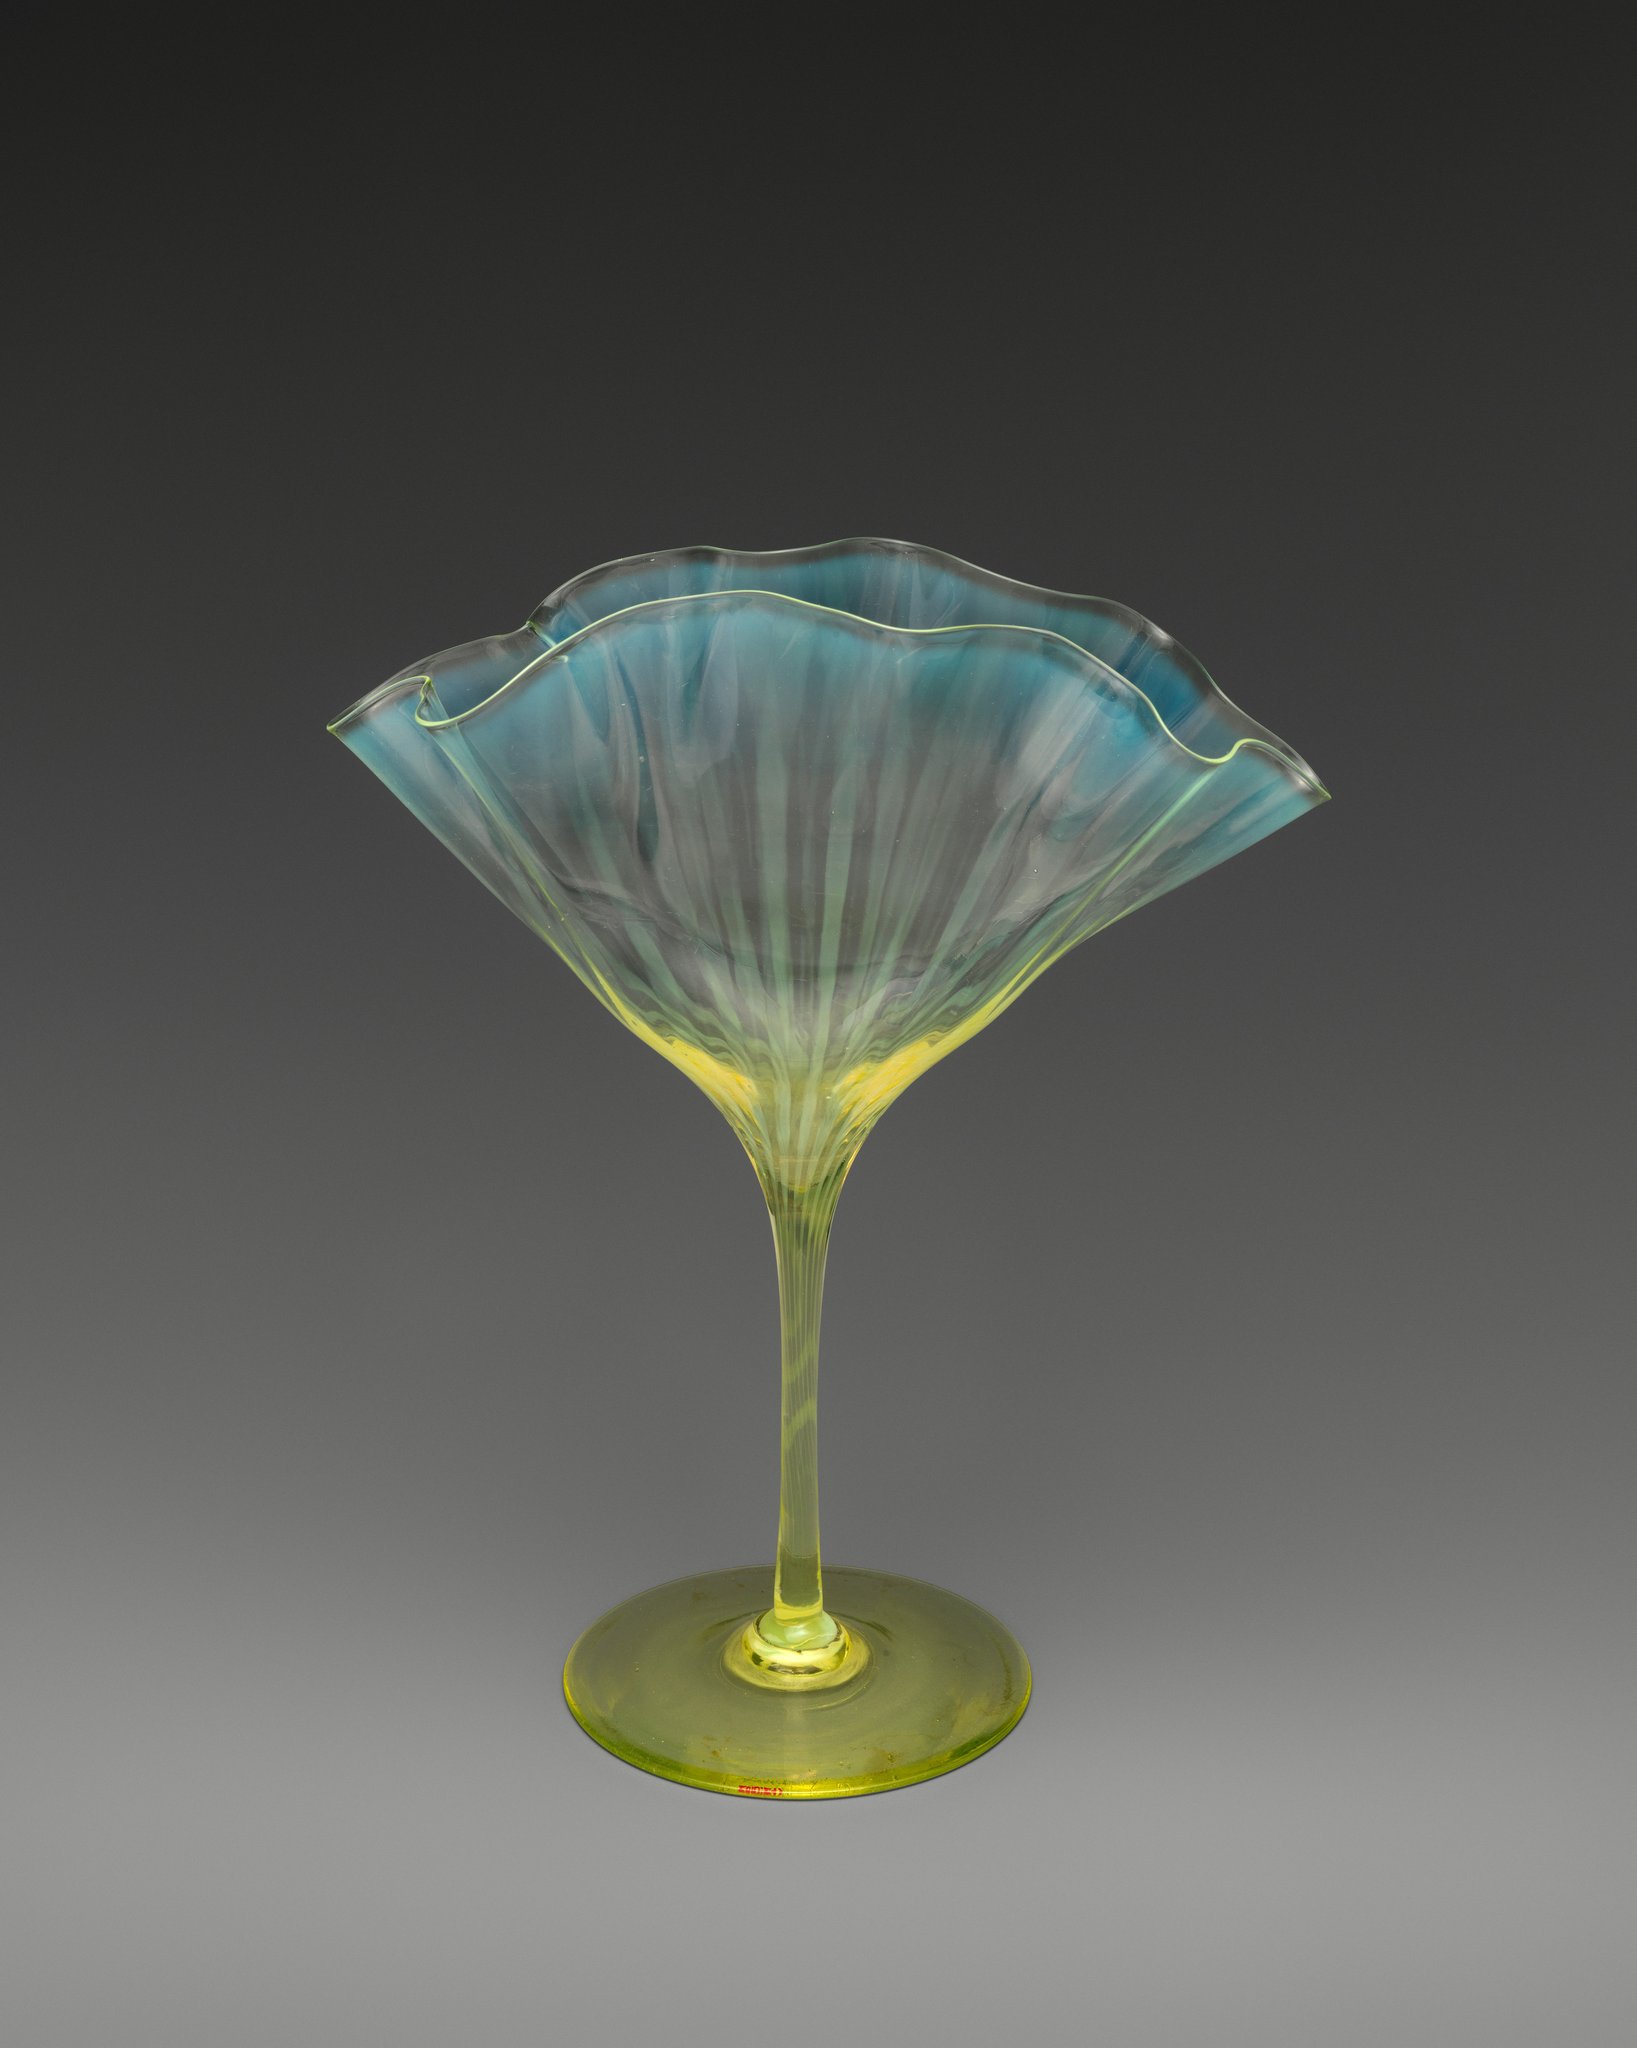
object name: vase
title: Fan-shaped vase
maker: harry powell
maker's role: designer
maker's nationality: british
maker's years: 1853-1922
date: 1890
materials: glass, fiber